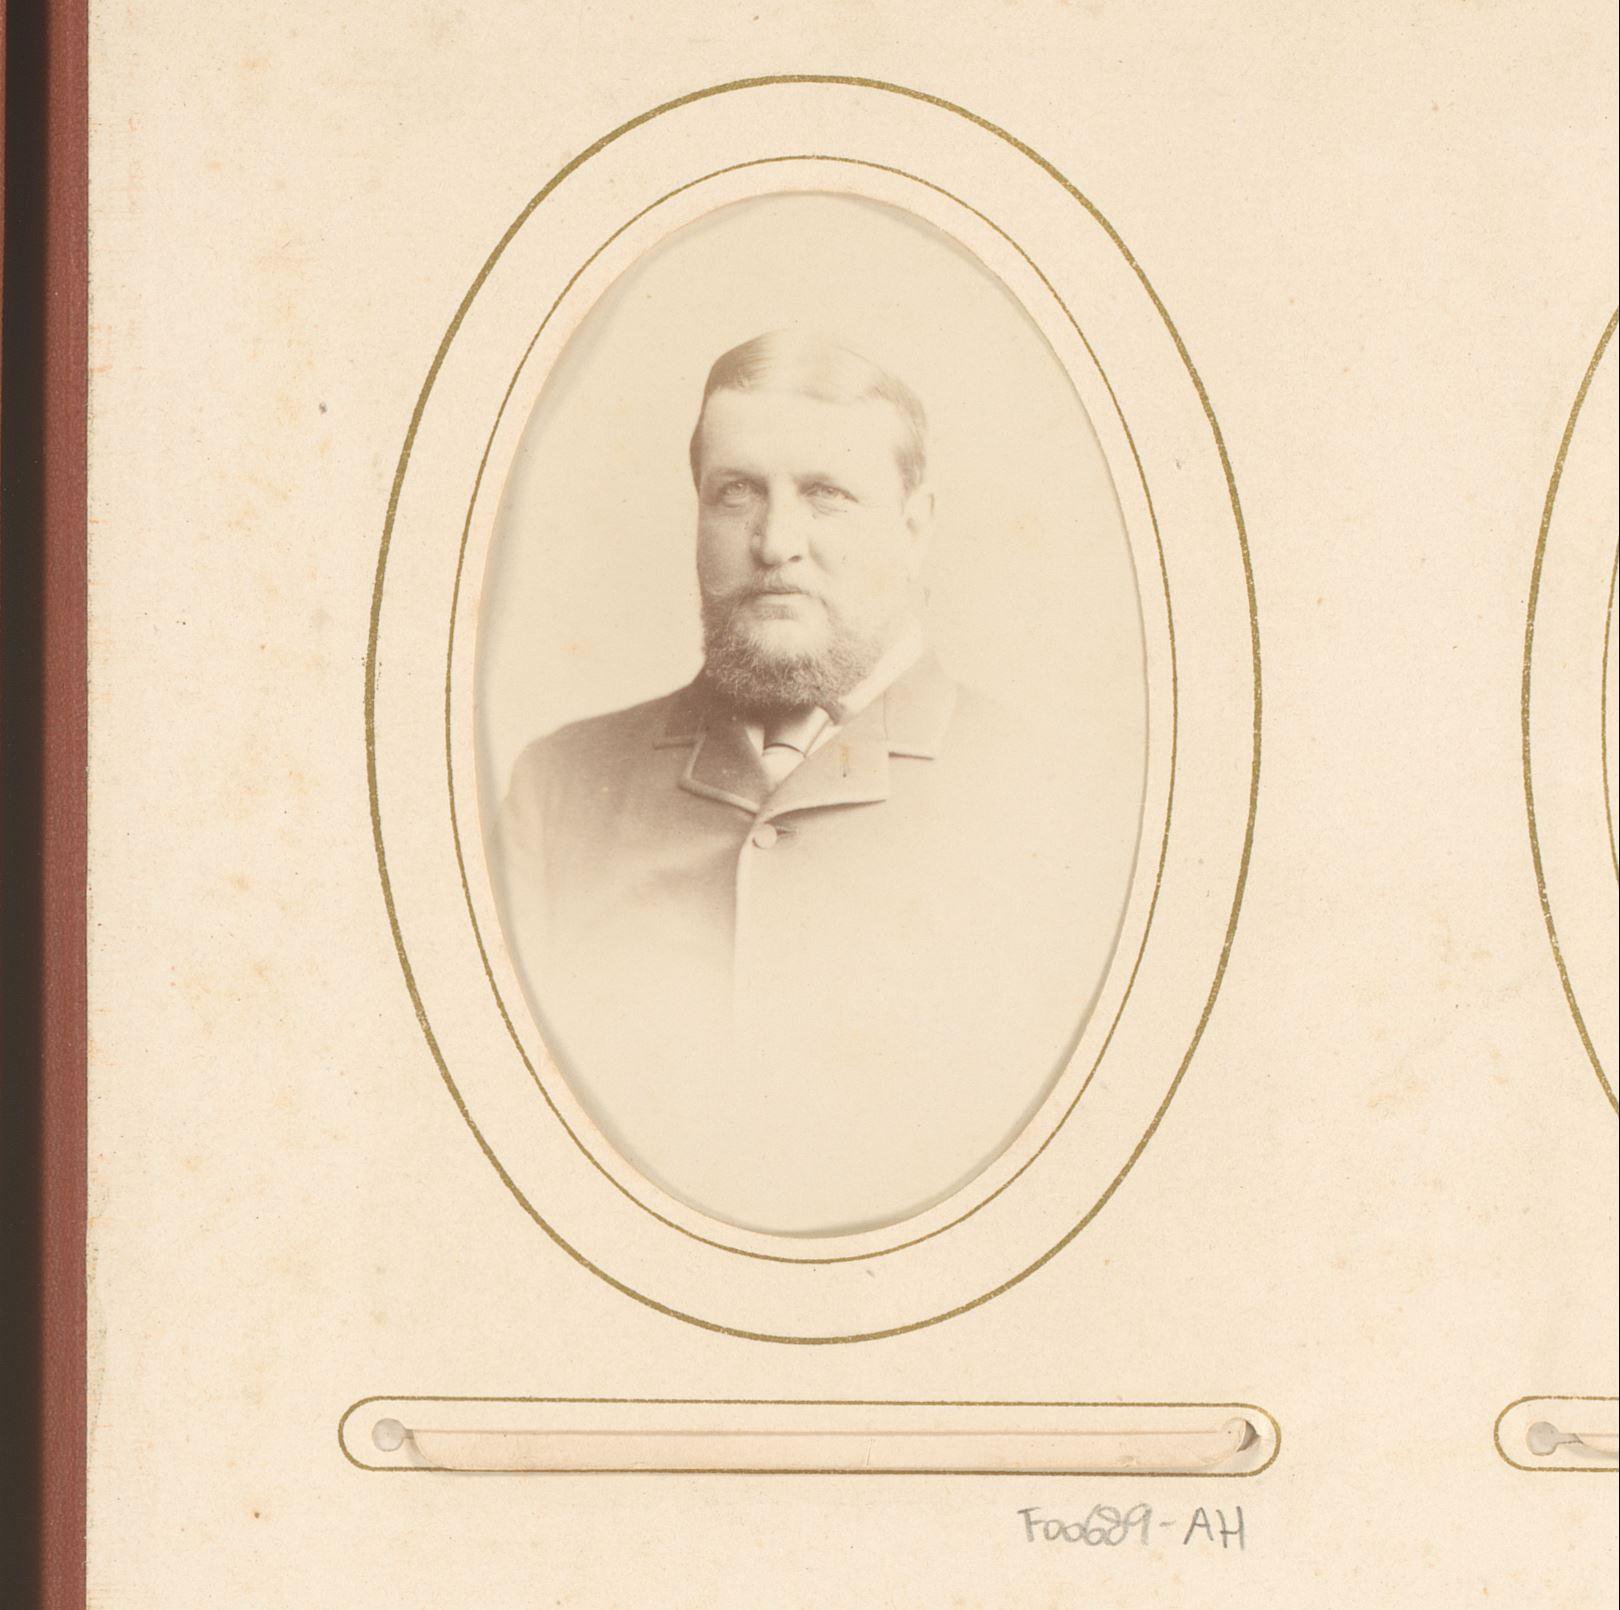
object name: photograph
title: Portret van een man met baard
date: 1860-1895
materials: cardboard, photographic support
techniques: albumen print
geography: england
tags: historical persons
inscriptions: inscription: ‘Negative No. 22994/ Position No. 5’, inscription: ‘Hills & Saunders/ Photogrpahers/ London (...)’